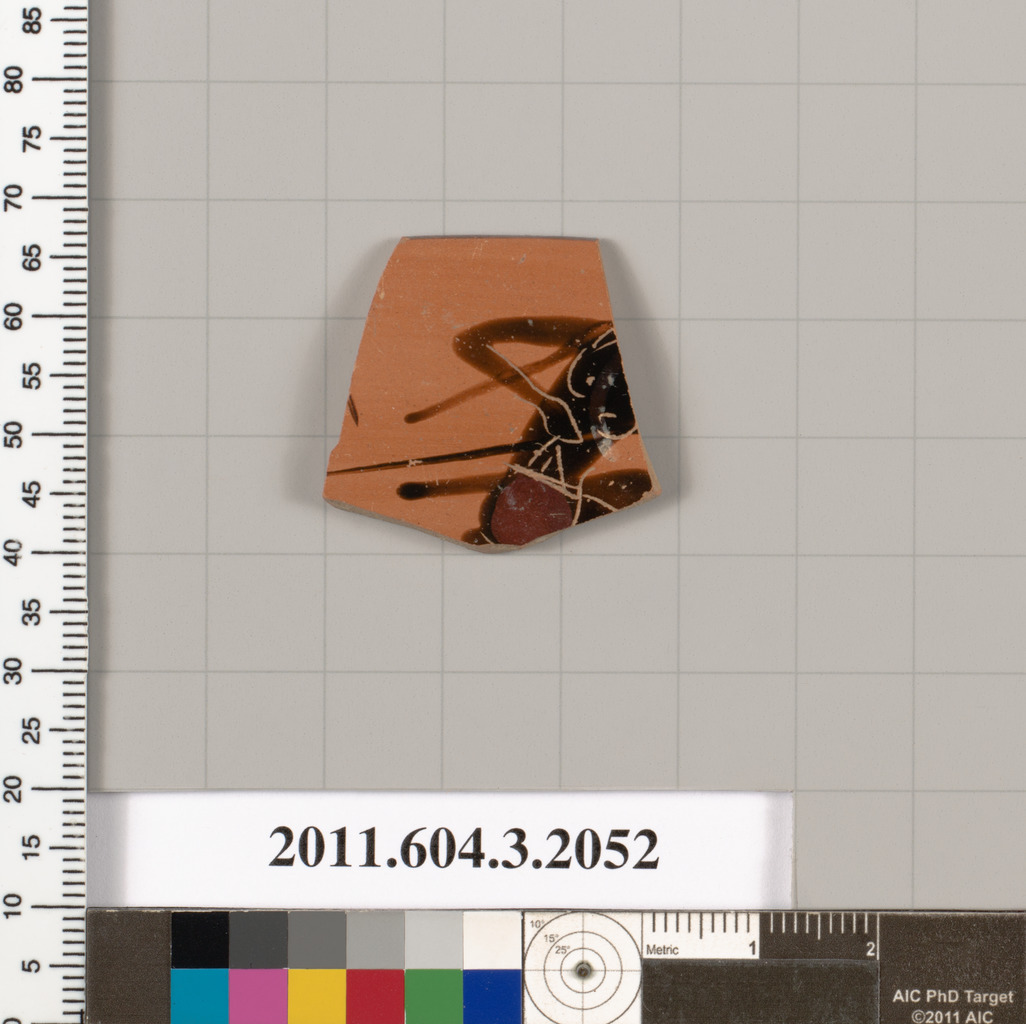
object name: kylix fragment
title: Terracotta rim fragment of a kylix (drinking cup)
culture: greek, attic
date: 500-468 BCE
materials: terracotta